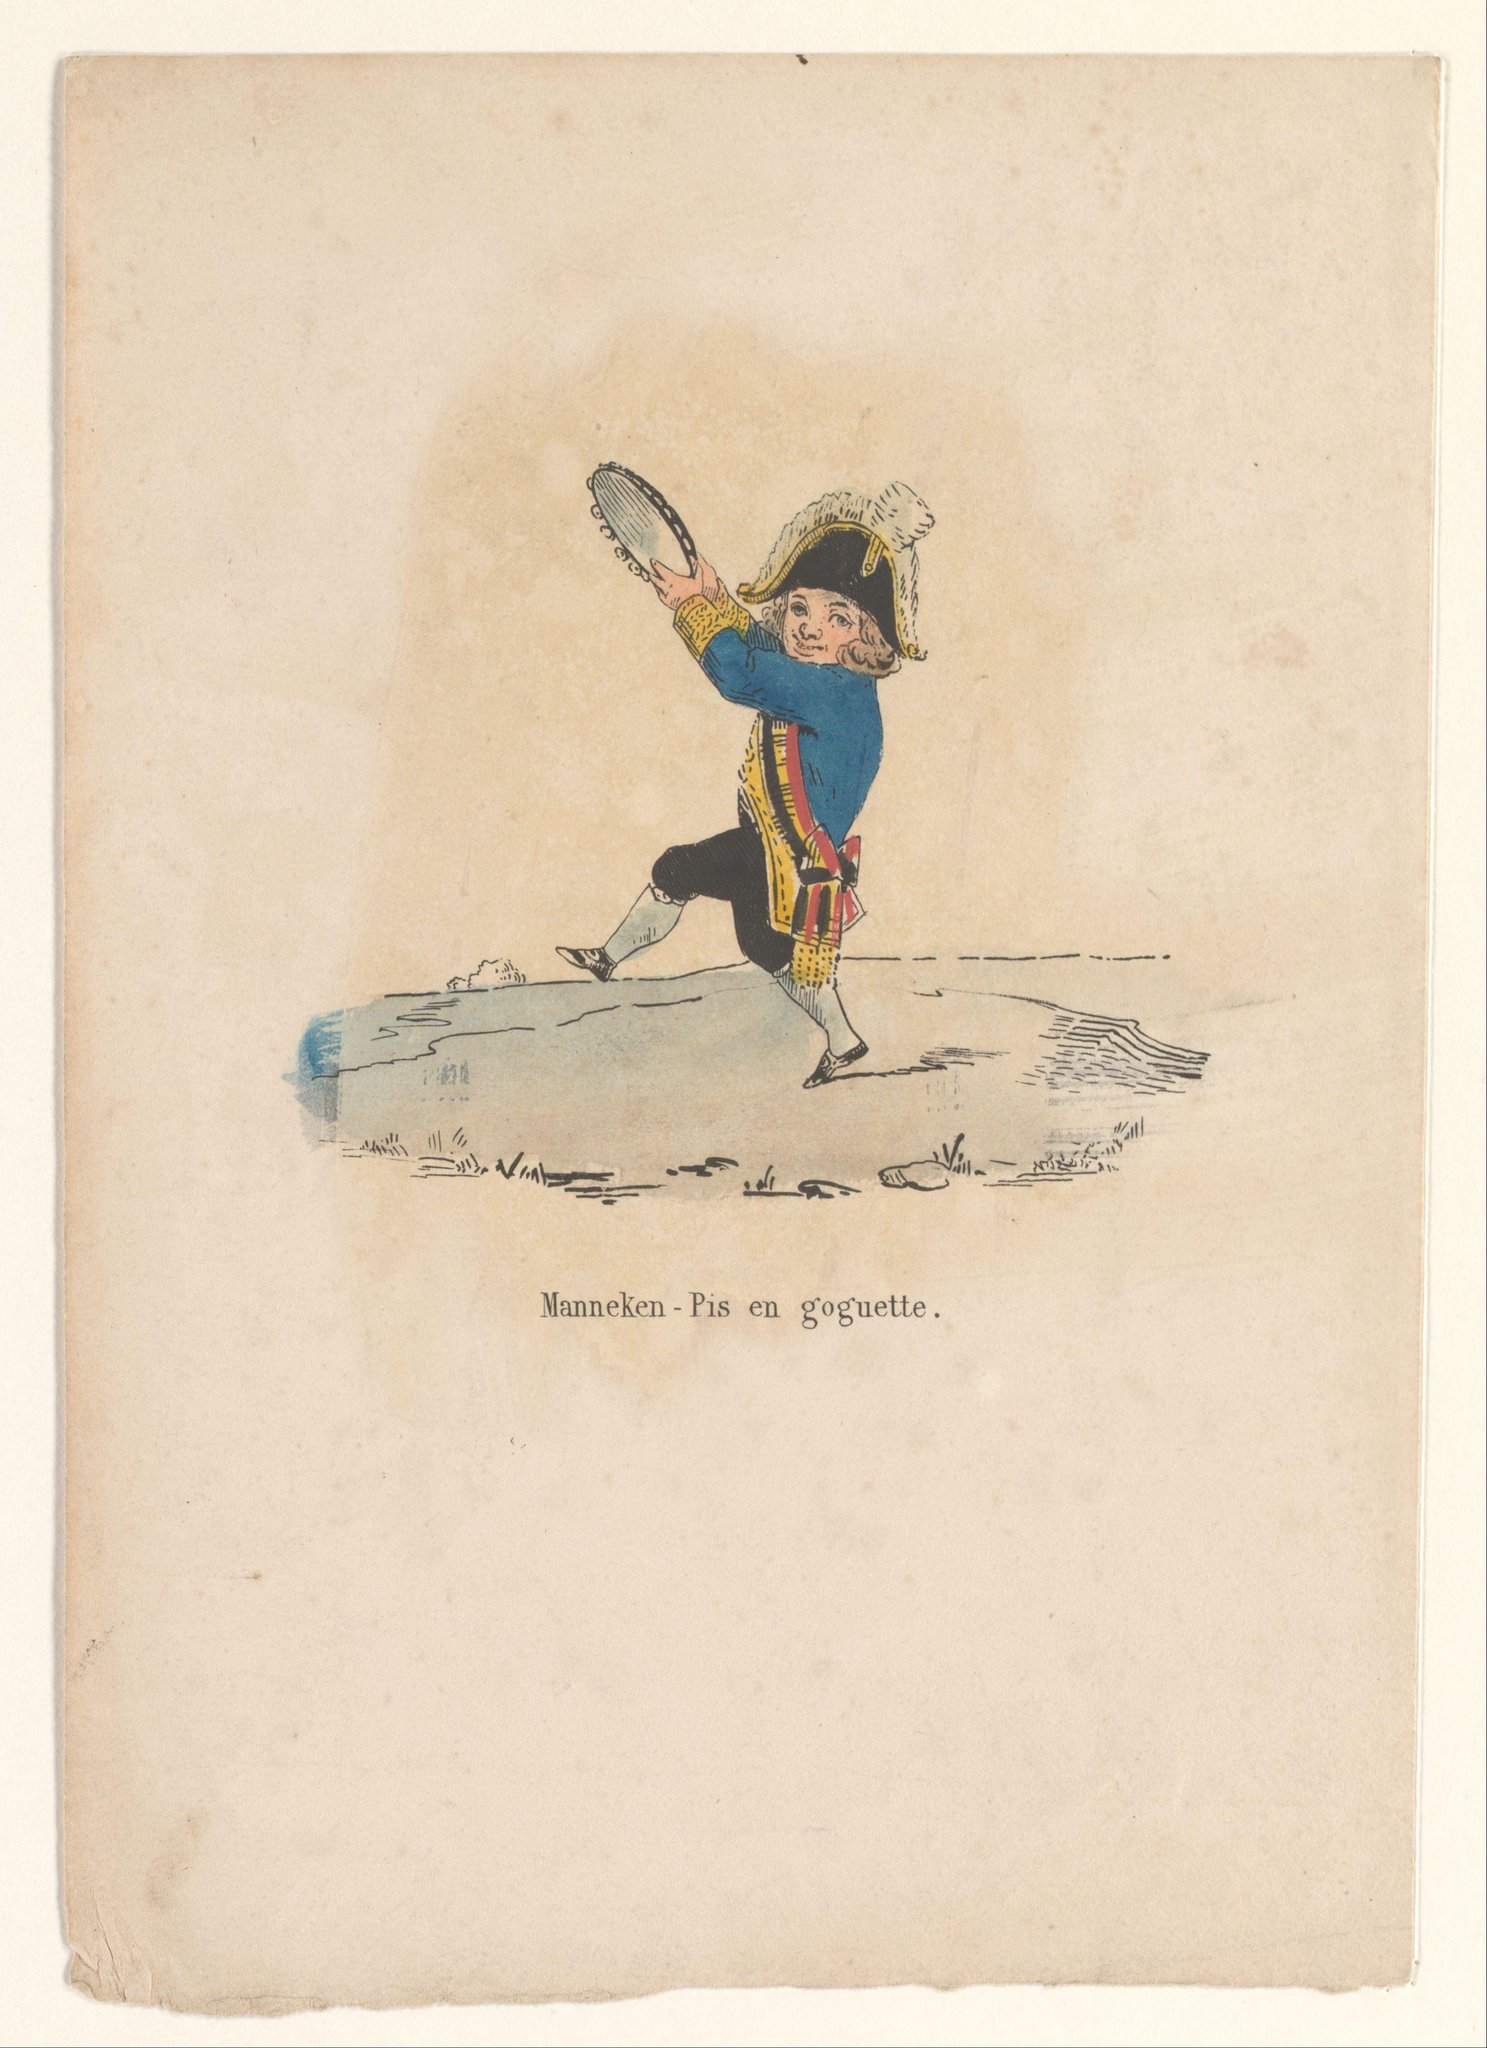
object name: print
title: Manneken-Pis en goguette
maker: Anonymous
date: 1830-1899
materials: paper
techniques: hand coloring, lithograph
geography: belgium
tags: tambourine - cc - out of doors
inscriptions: collector's mark: Lugt 2228